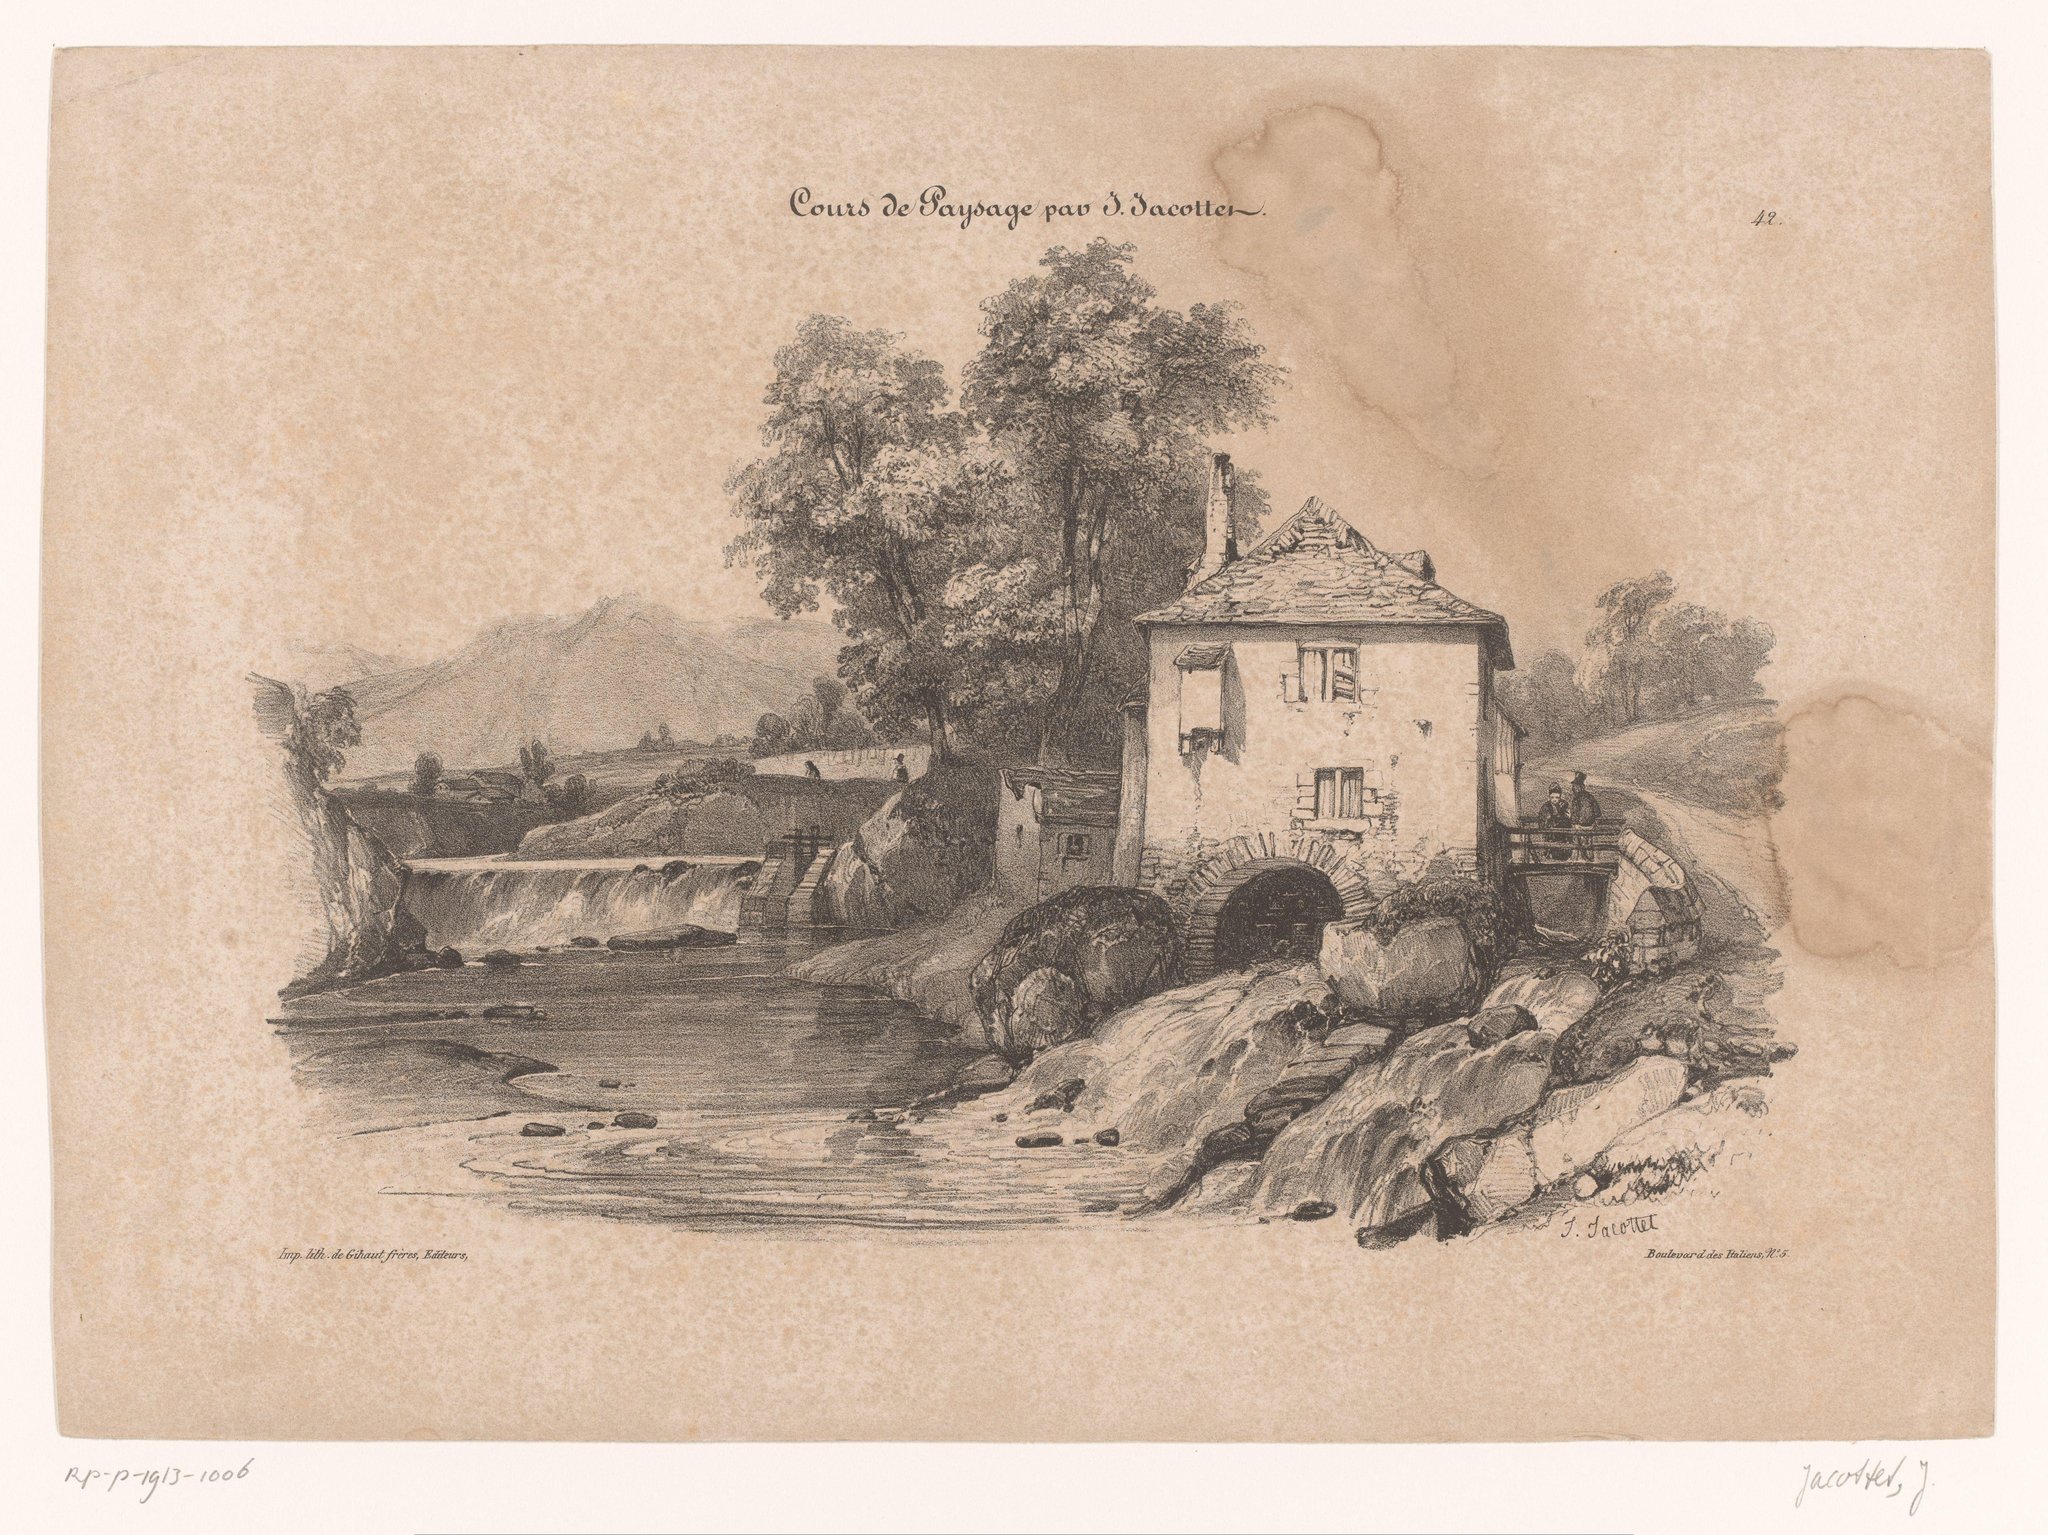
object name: print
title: Huis aan een bergbeek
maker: louis-julien jacottet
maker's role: painter, print maker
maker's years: 1806-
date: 1836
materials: paper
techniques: lithograph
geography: paris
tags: rural housing, e.g. country-house, villa, cottage, mountains (+ landscape with figures, staffage), brook (+ landscape with figures, staffage)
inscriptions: collector's mark: Lugt 2228a